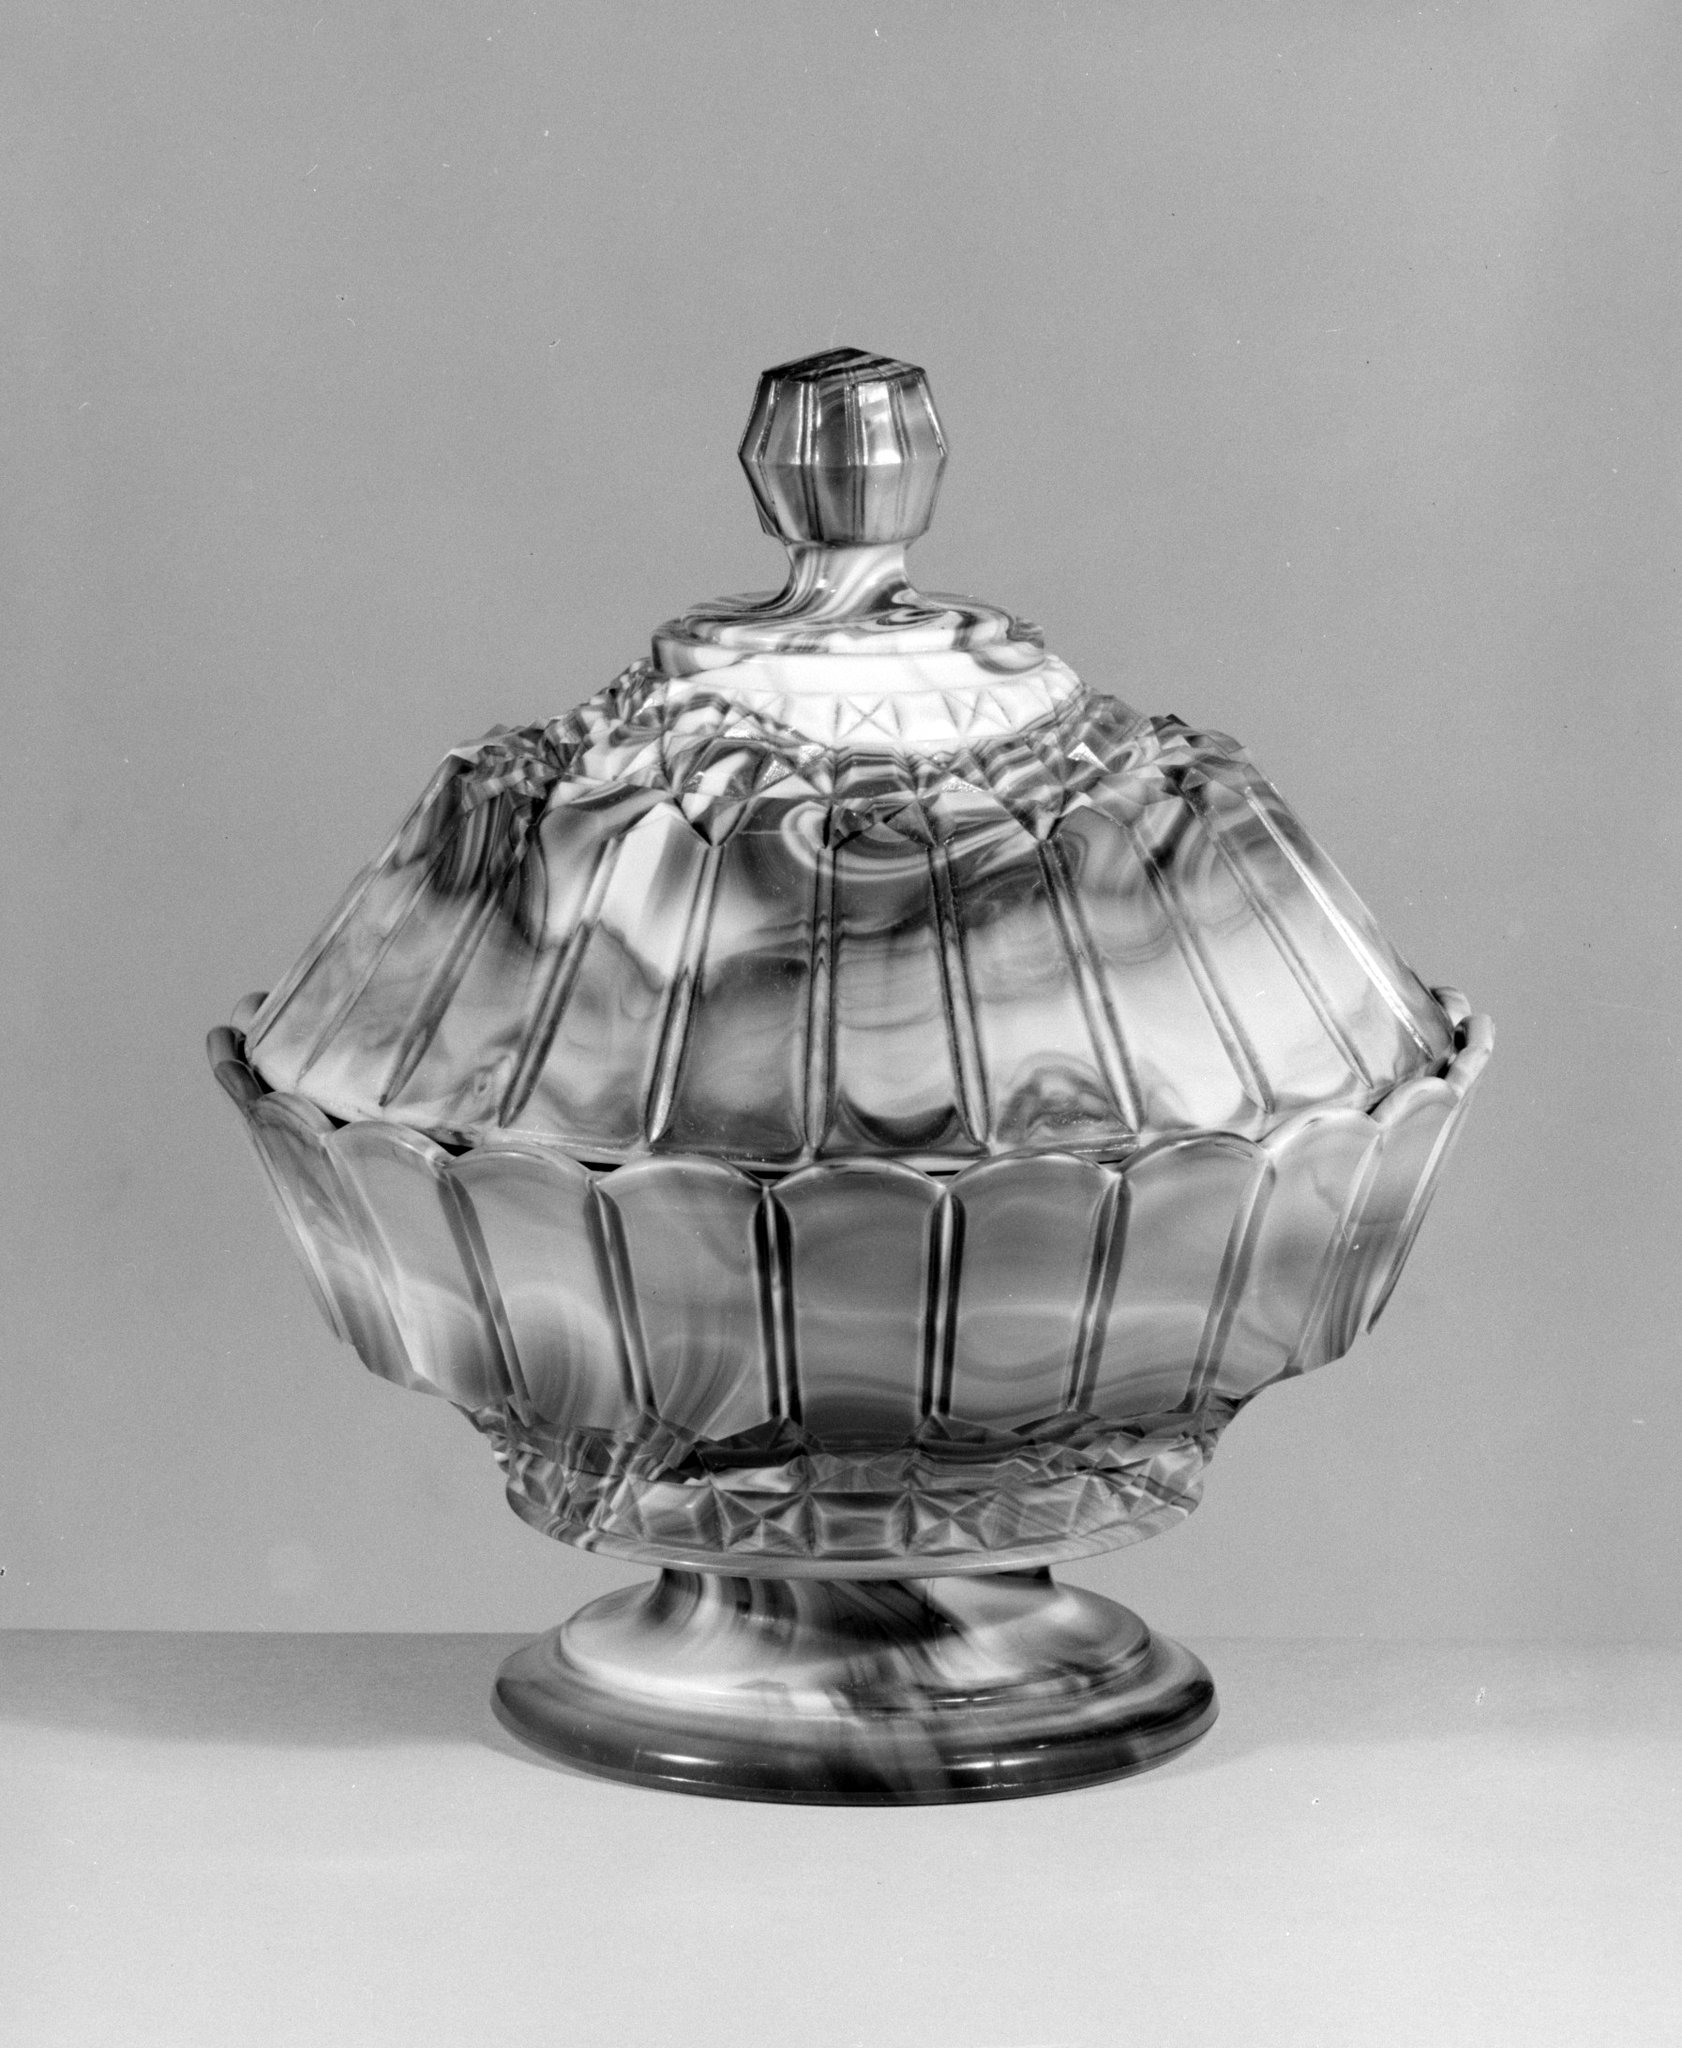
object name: bowl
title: Purple marble glass covered bowl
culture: american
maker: challinor, taylor and company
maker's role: maker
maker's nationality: american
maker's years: 1866-1891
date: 1870-1890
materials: glass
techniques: pressed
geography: united states